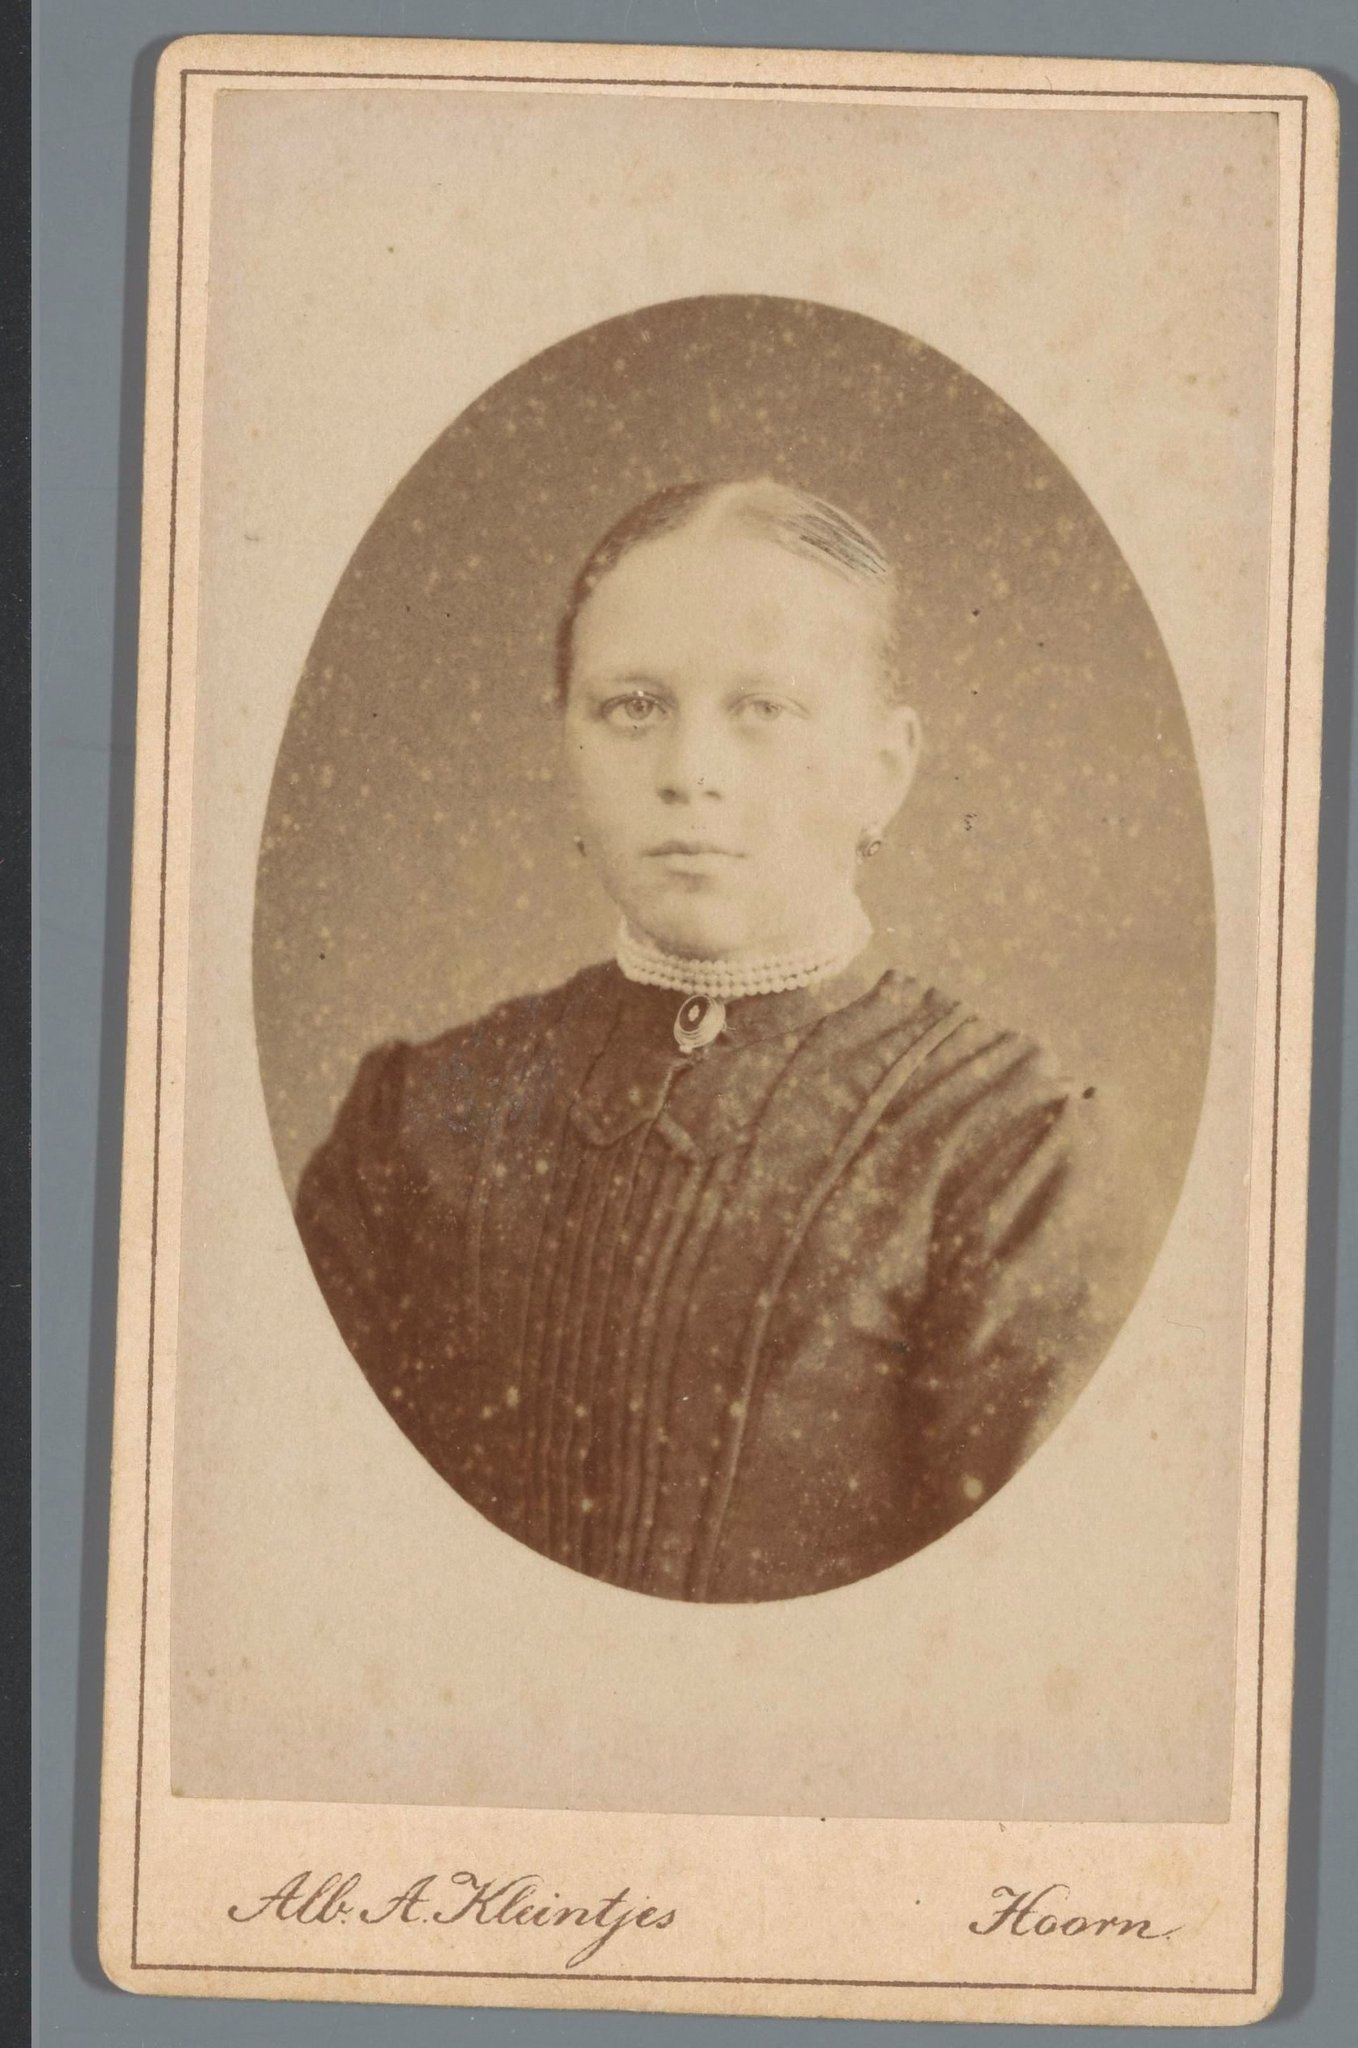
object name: photograph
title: Portret van Grietje Visser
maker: albert a. kleintjes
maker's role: fotograaf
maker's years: 1854-1942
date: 1883-1900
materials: cardboard, paper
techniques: albumen print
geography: hoorn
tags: adult woman, historical persons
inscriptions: inscription: ‘Nabestellingen en Vergrootingen van deze en andere/ Portretten kunnen ten allen tijde geleverd worden.’, address: ‘Hoorn/ Kerkstraat,/ 4e huis v.d. Kaasmarkt.’